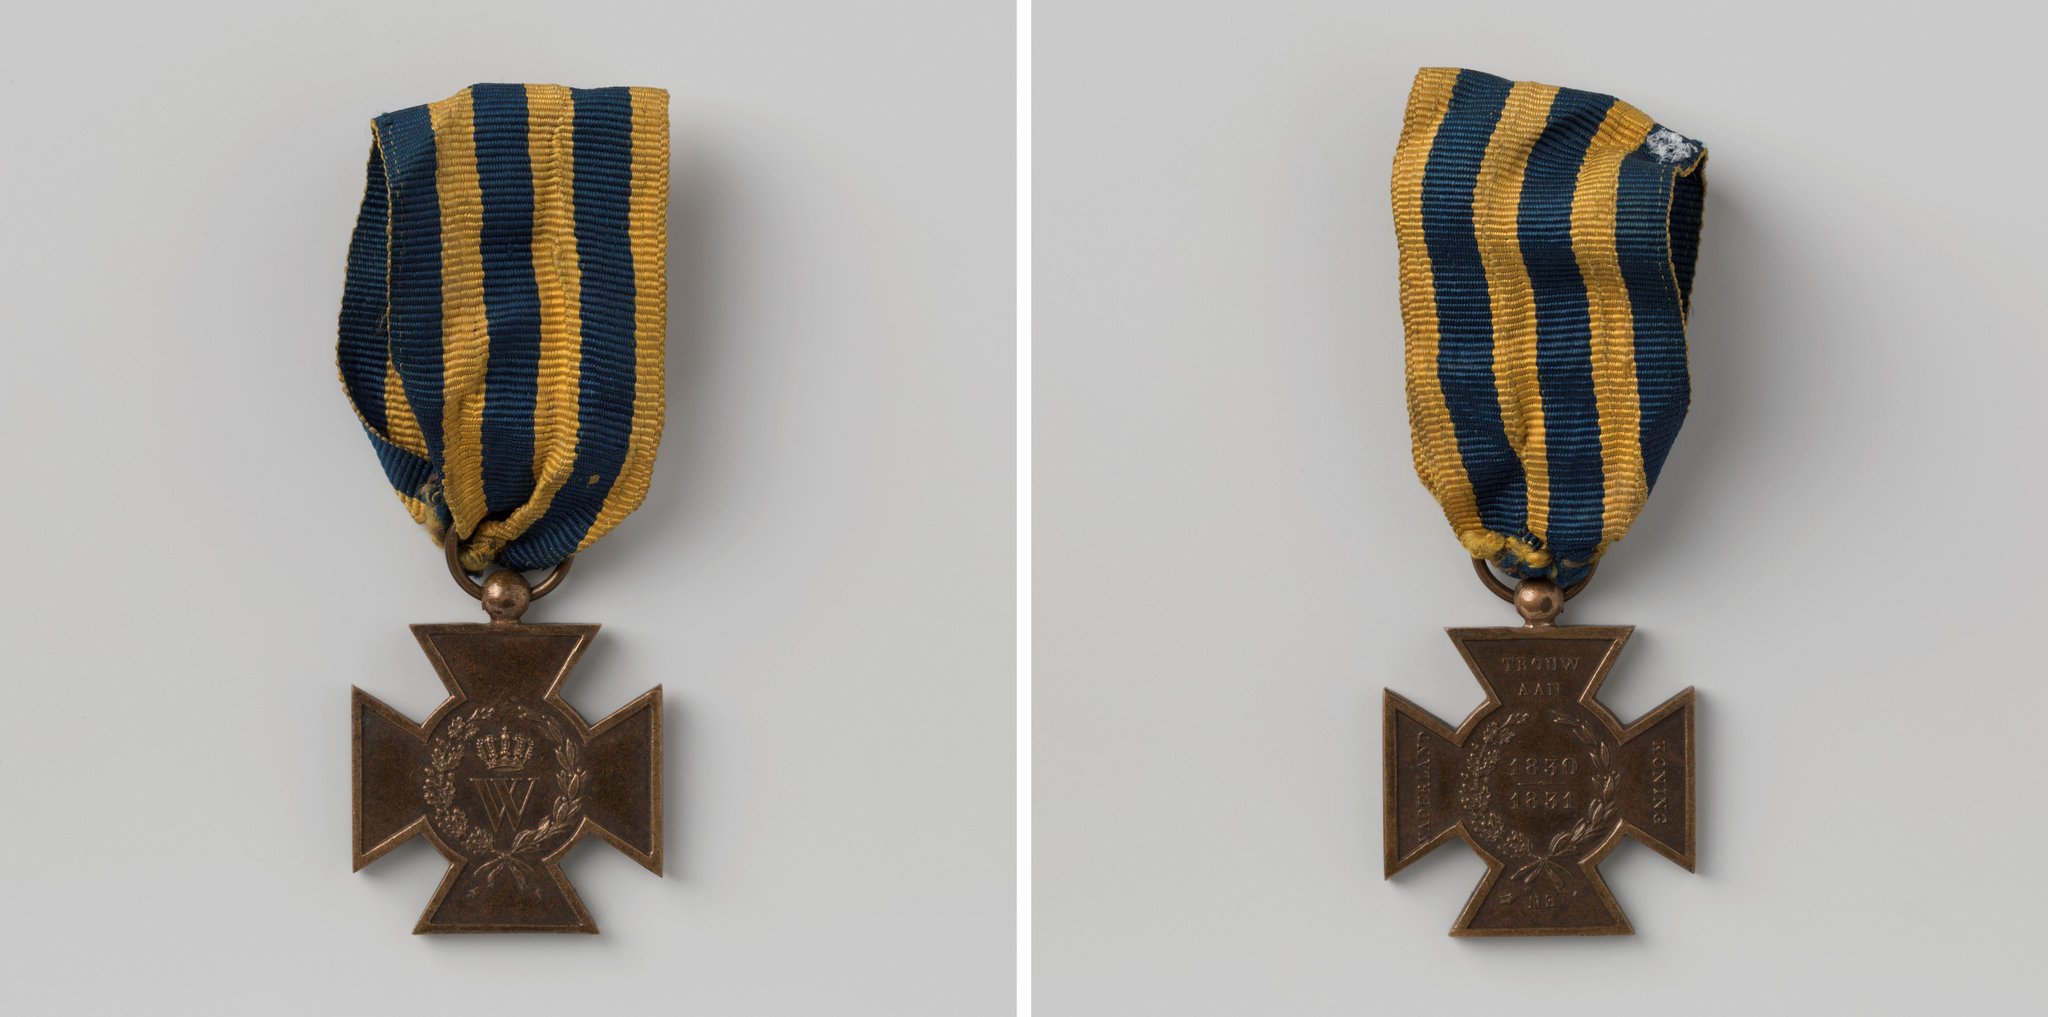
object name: draagpenning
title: Metalen Kruis 1831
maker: david van der kellen (1804-1879)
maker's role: die cutter, draughtsman, print maker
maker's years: 1804-1879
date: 1831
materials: bronze, textile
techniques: striking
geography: utrecht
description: Bronzen kruis met bal en draagring aan een blauw-geel gestreept lint, op de voorzijde een gekroonde letter W tussen samengestrikte eiken- en lauwertakken, op de keerzijde 1830-1831 tussen samengestrikte eiken- en lauwertakken, op de benen TROUW AAN - KONING - EN - VADERLAND